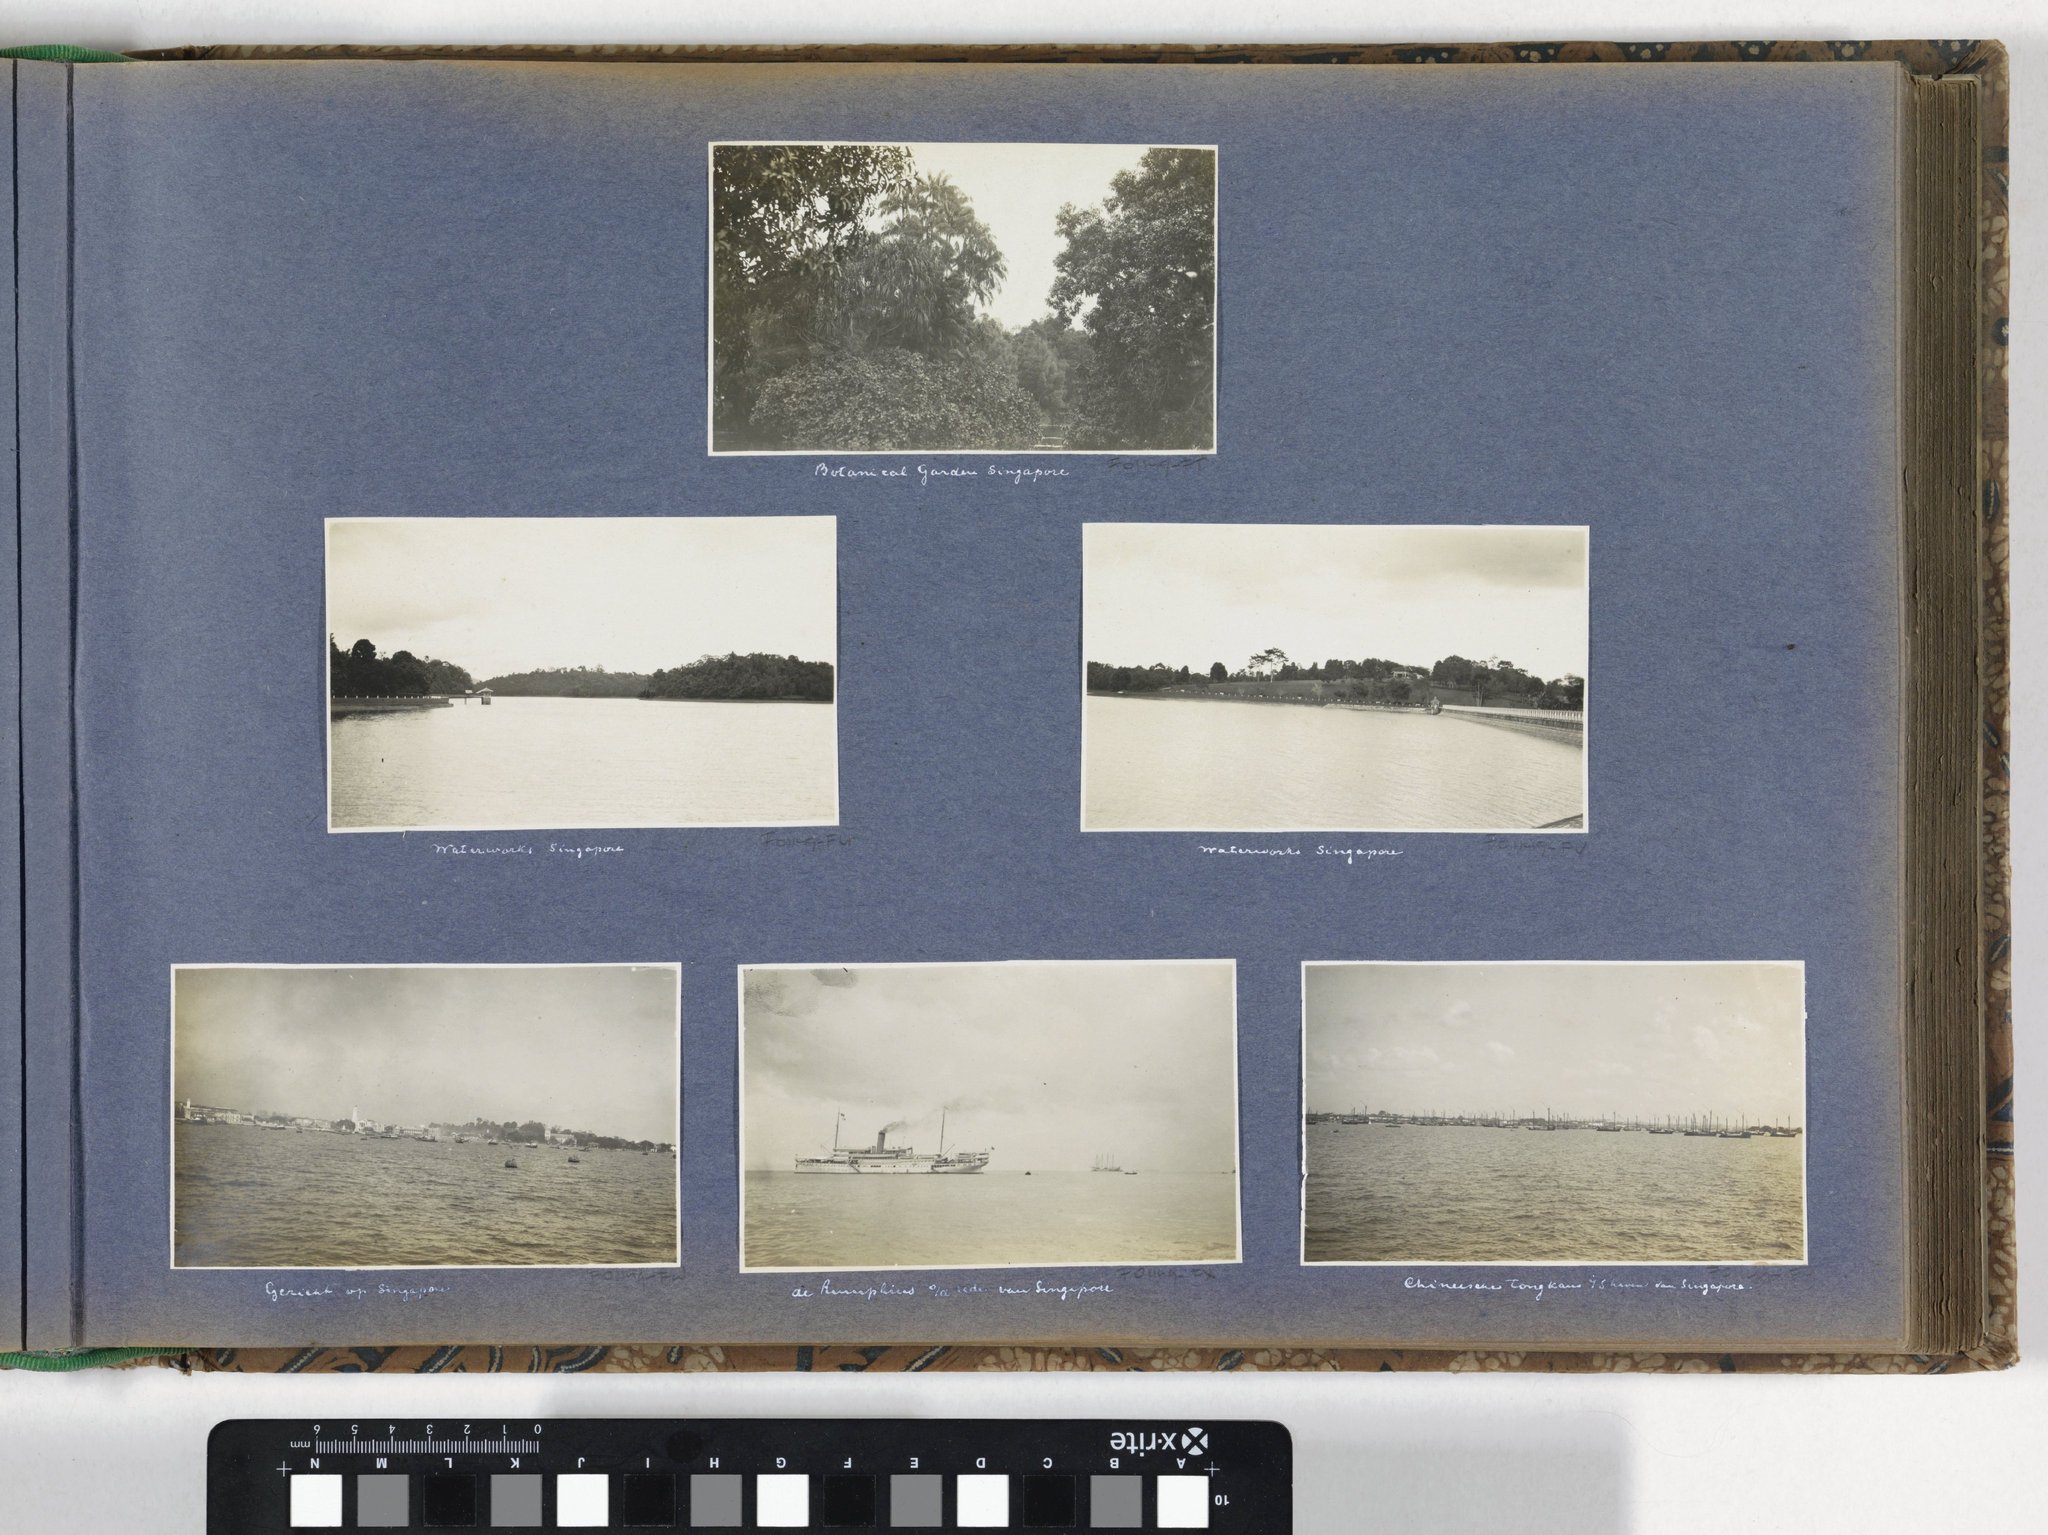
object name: album leaf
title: Chinese schepen (tongkans) in haven van Singapore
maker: Anonymous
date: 1908-1920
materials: paper, photographic support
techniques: gelatin silver print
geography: singapore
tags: harbour (+ view ~ vehicle, ship, etc.), singapore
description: Onderdeel van reisalbum met foto's van bedrijvigheid en bezienswaardigheden op Sumatra en Java en van de reis naar en van Nederlands-Indië.